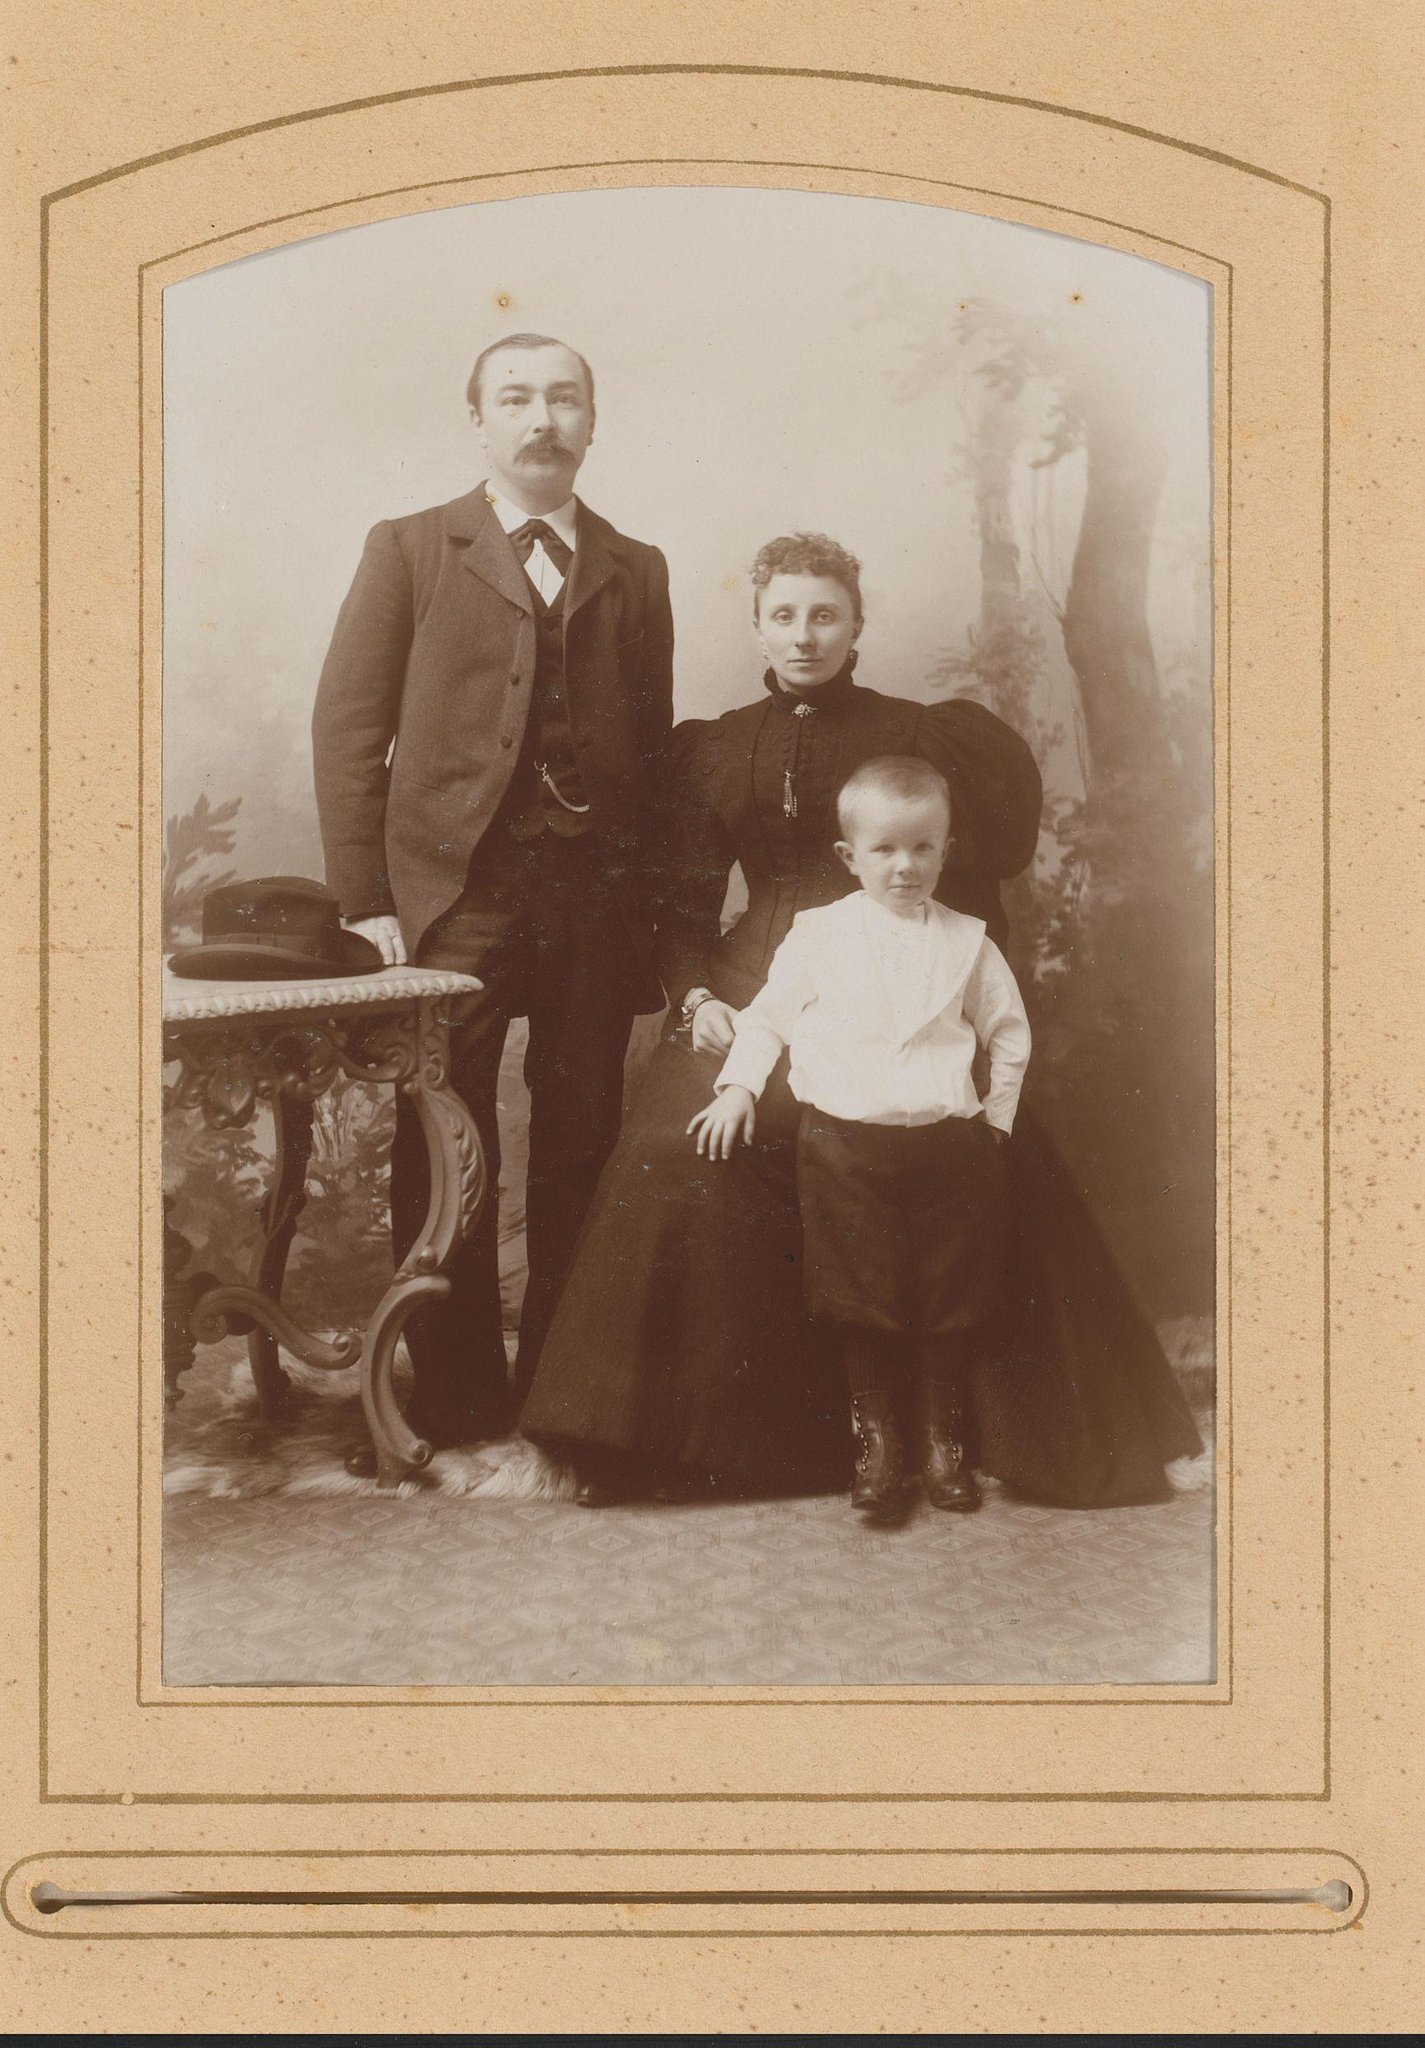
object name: album leaf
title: Groepsportret met een man, vrouw en jongen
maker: e. visser von weeren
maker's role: fotograaf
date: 1890-1920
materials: cardboard, photographic support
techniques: collodion silver print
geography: the hague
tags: family group, especially parents with their child(ren)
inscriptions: inscription: ‘Visser van Weeren/ fotograaf/ Den Haag/ Kortenaerkade No.1 / hoek Anna Paulownastr.’